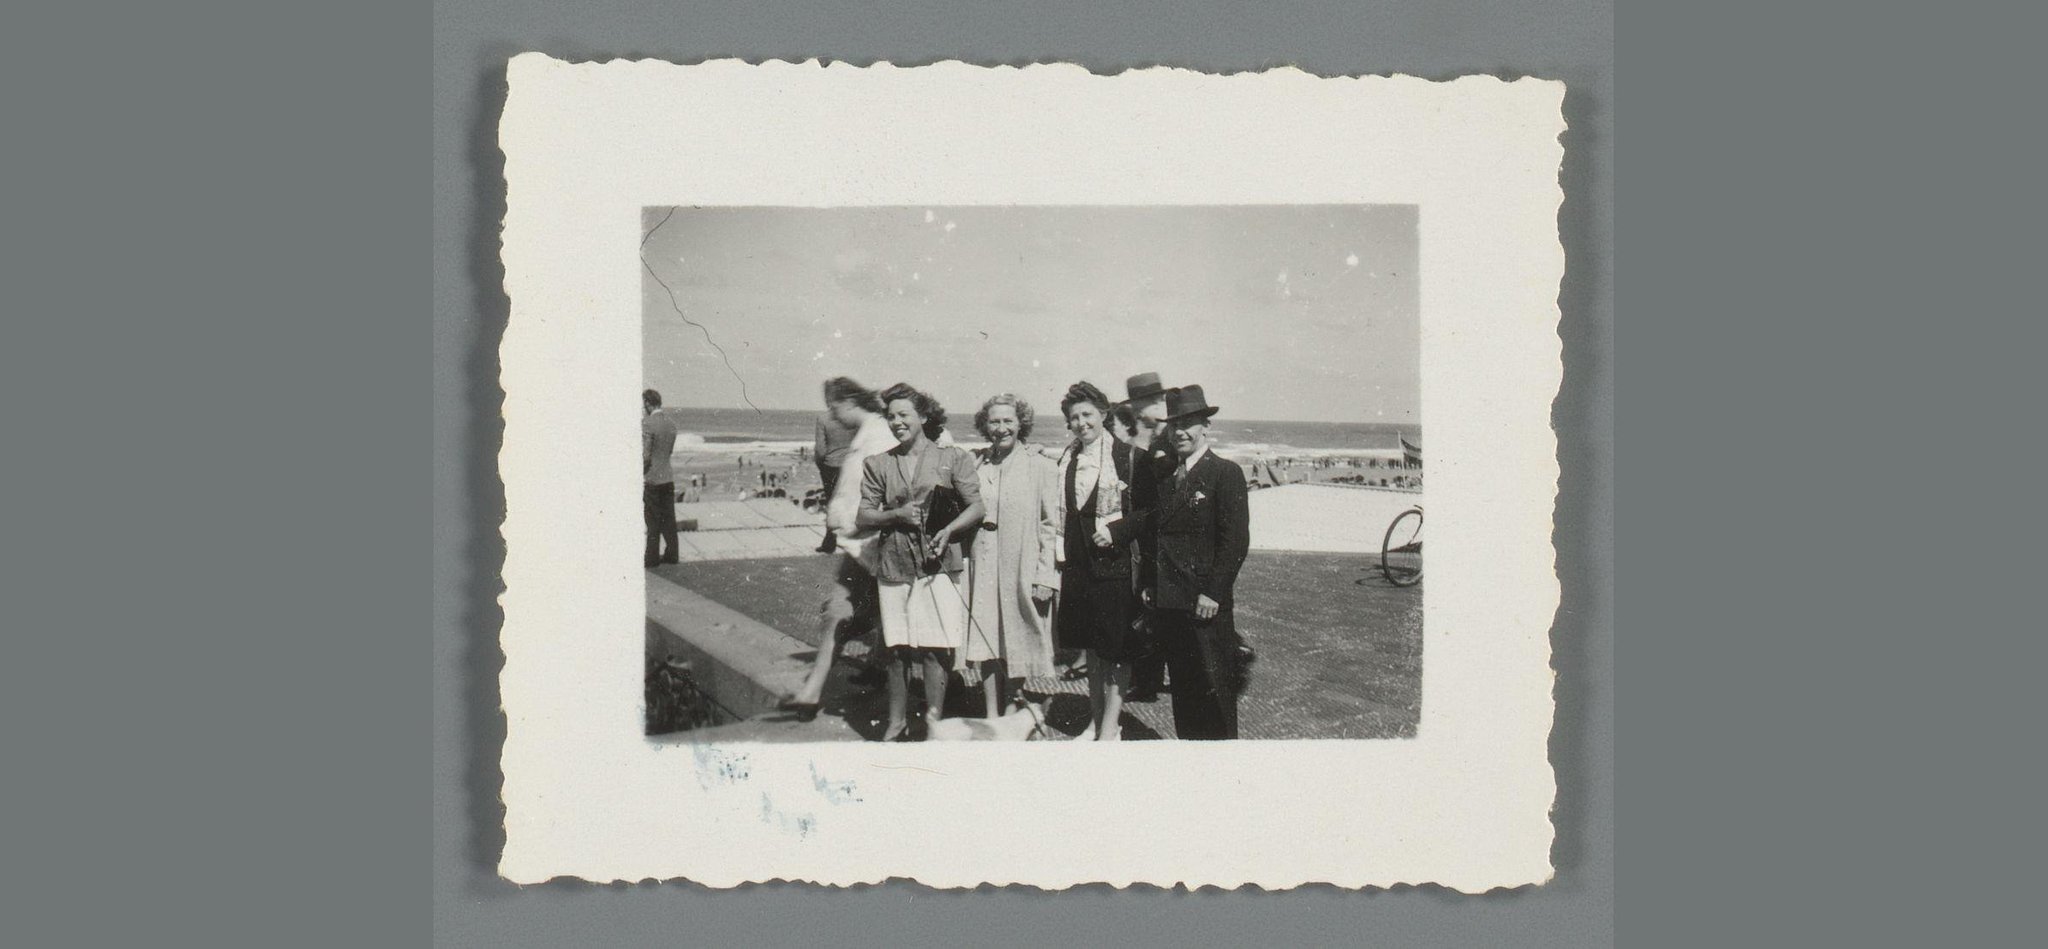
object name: photograph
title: Groepsportret van drie onbekende vrouwen en een man langs het strand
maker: Anonymous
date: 1946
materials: paper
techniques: gelatin silver print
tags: beach (as place of recreation), anonymous historical persons portrayed in a group, in a group-portrait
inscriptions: date: ‘1946’, inscription: ‘VB2’